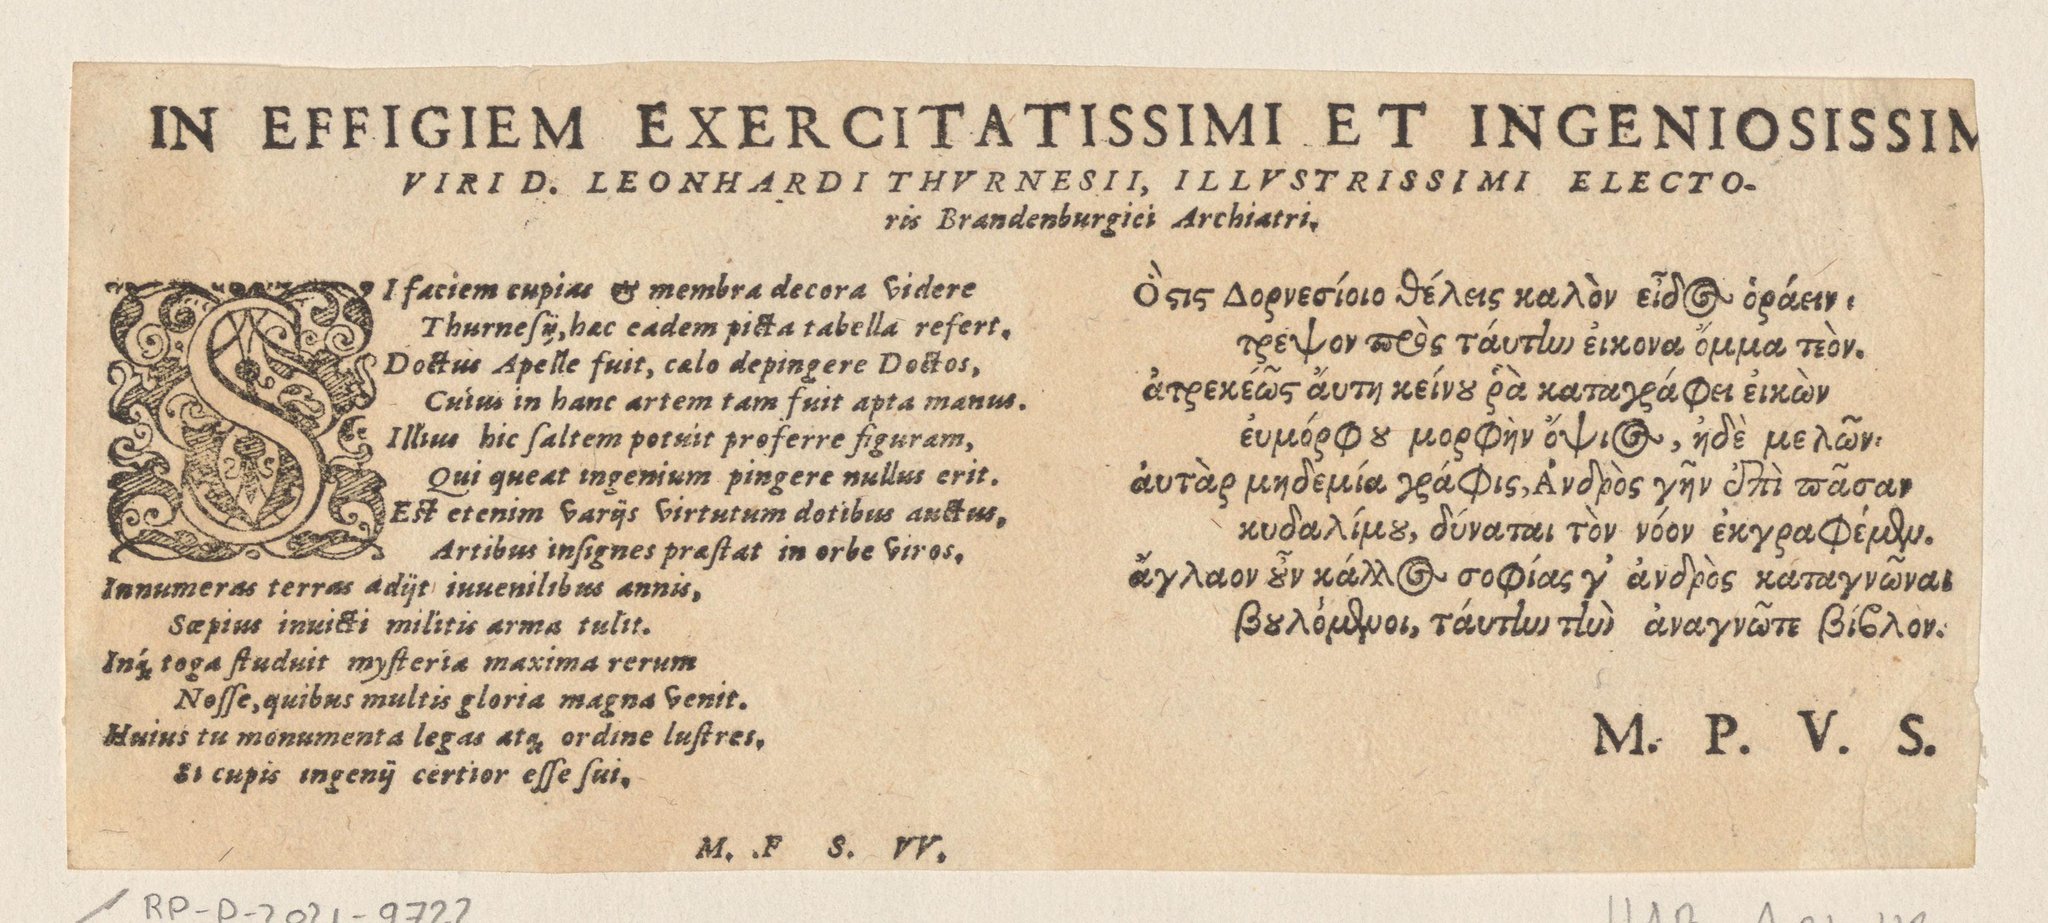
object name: text sheet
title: Tekstblad bij een portret van Leonhard Thurneisser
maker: Anonymous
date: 1578-1587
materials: paper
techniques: letterpress printing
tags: cologne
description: Tekstblad uit: Thurneisser, Leonhard. Historia sive descriptio plantarum omnium (...). Berlijn: Michael Hentzke, 1578. Ook gebruikt in de 1587-editie, uitgegeven door Johann Gymnich te Keulen.